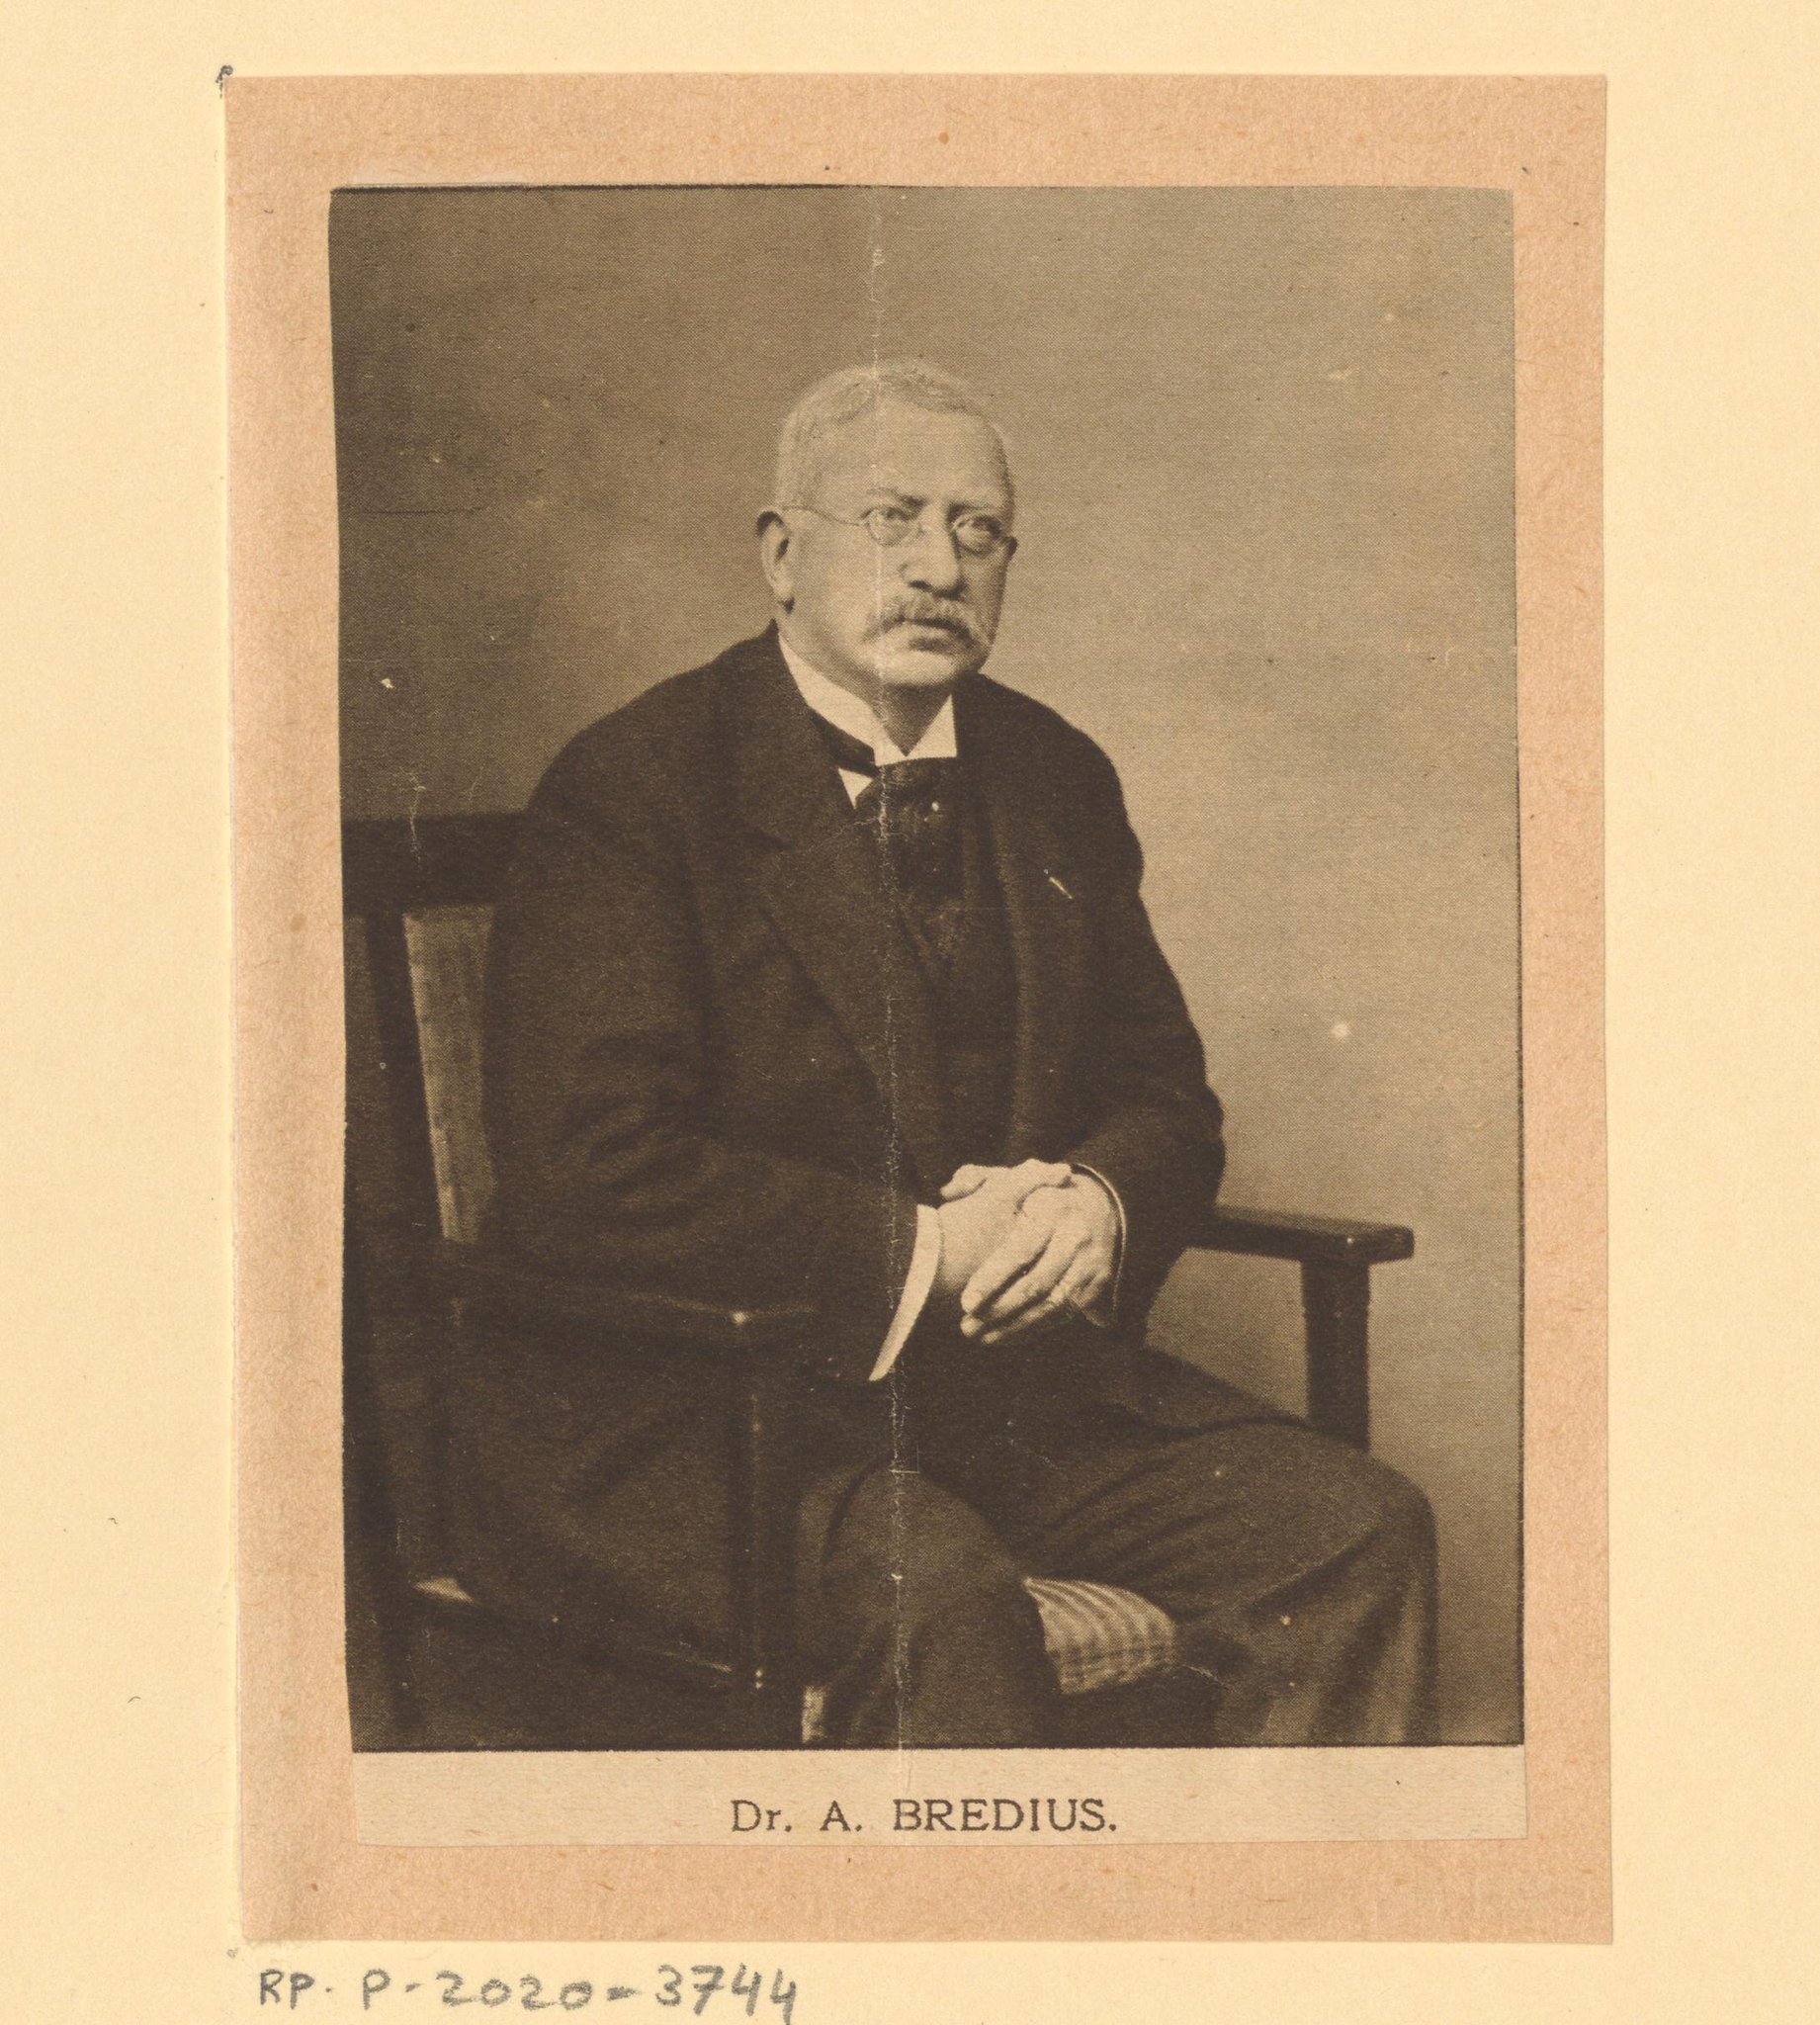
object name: photomechanical print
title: Portret van Abraham Bredius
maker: Anonymous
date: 1900-1949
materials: paper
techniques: rotogravure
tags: amsterdam, abraham bredius, historical persons